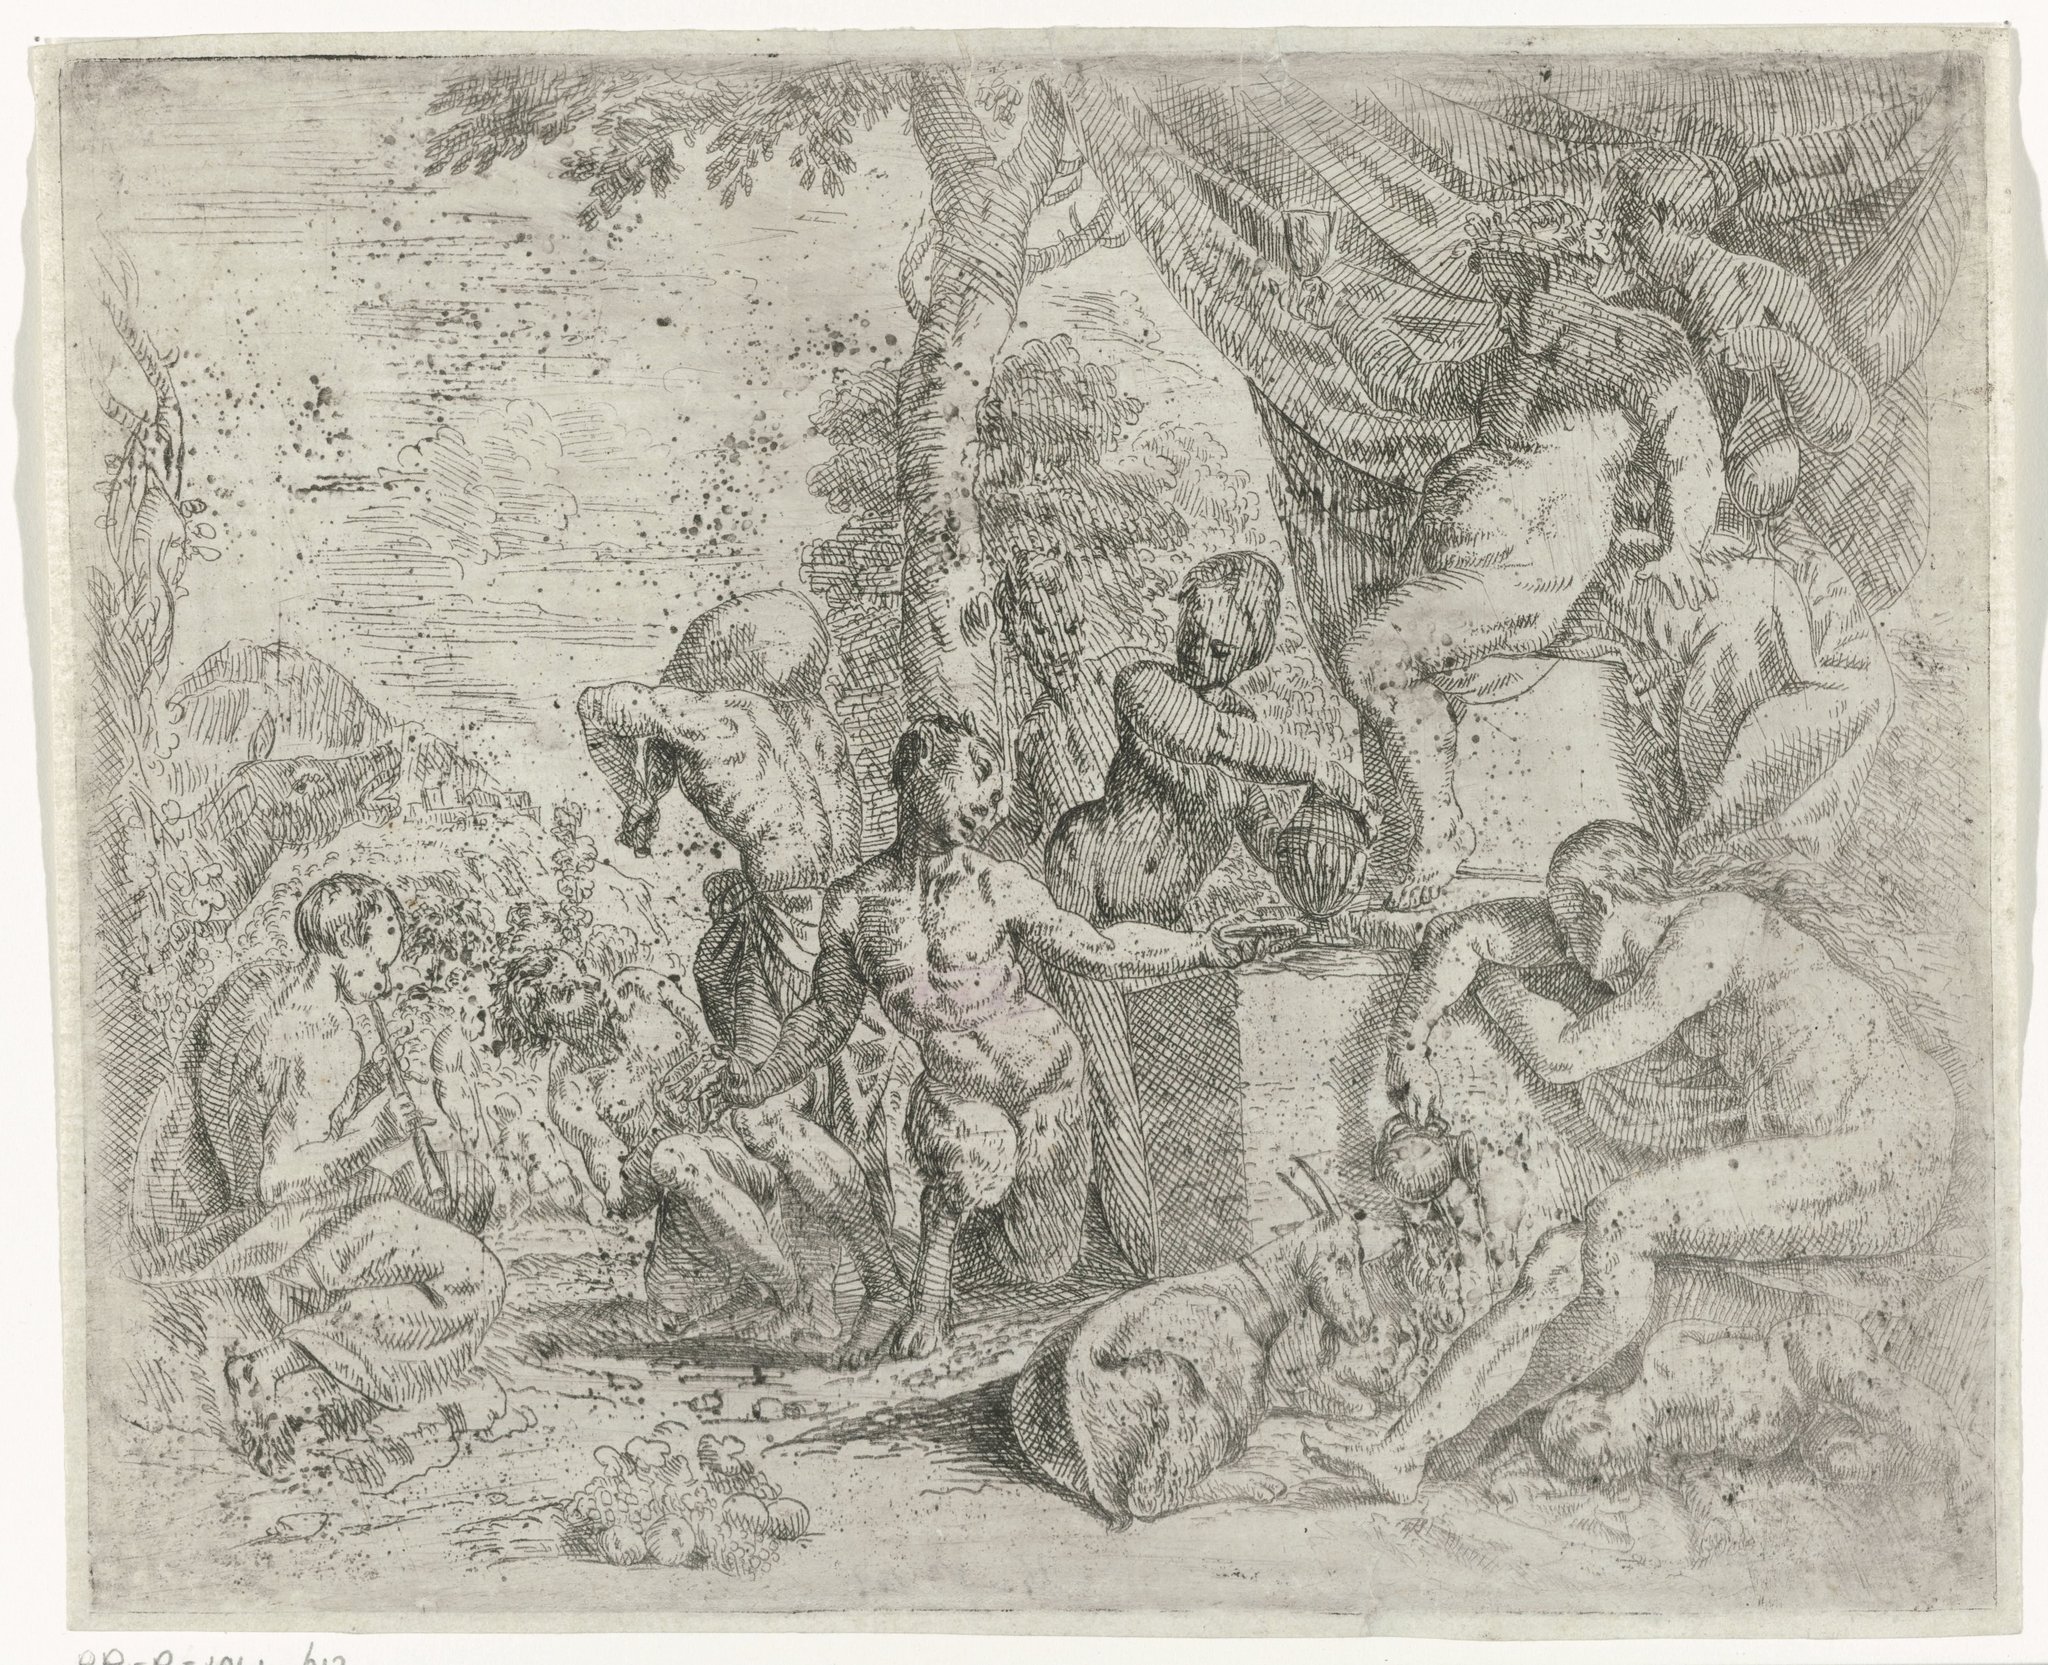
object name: print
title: Bacchanaal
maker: Anonymous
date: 1600-1700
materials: paper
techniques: etching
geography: netherlands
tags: offspring, companion(s), train etc. of bacchus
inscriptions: collector's mark: Lugt 240, collector's mark: Lugt 2228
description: Rechtsboven Bacchus zittend op een stenen troon onder een baldakijn. Om hem heen drinkende en roes uitslapende saters. Links een fluitspelende sater.